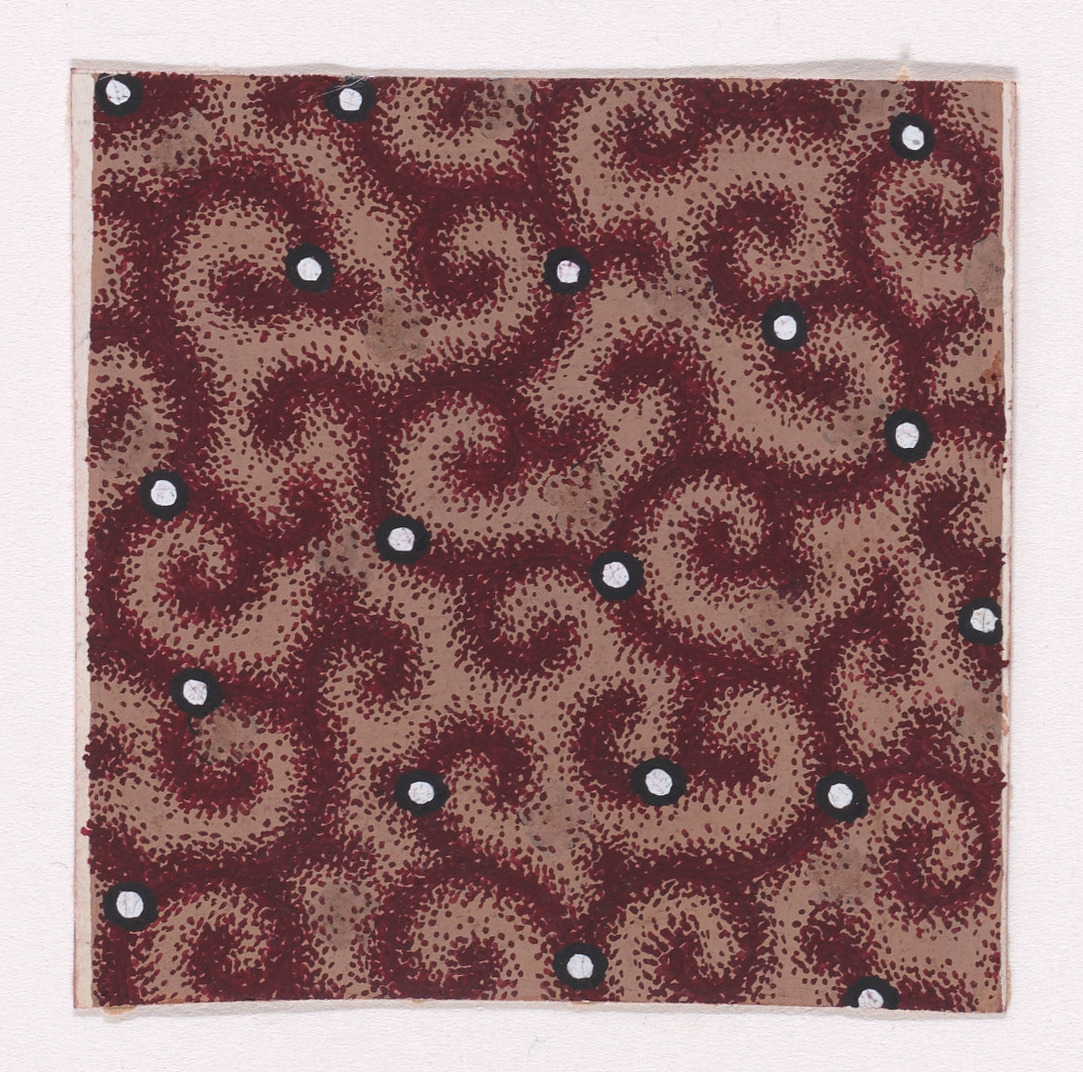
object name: drawing ornament architecture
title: Textile Design of Scattered Pealrs over a Background of Scrolling Branches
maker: anonymous, alsatian, 19th century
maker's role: artist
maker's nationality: alsatian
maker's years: 1800-1900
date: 1840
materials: gouache